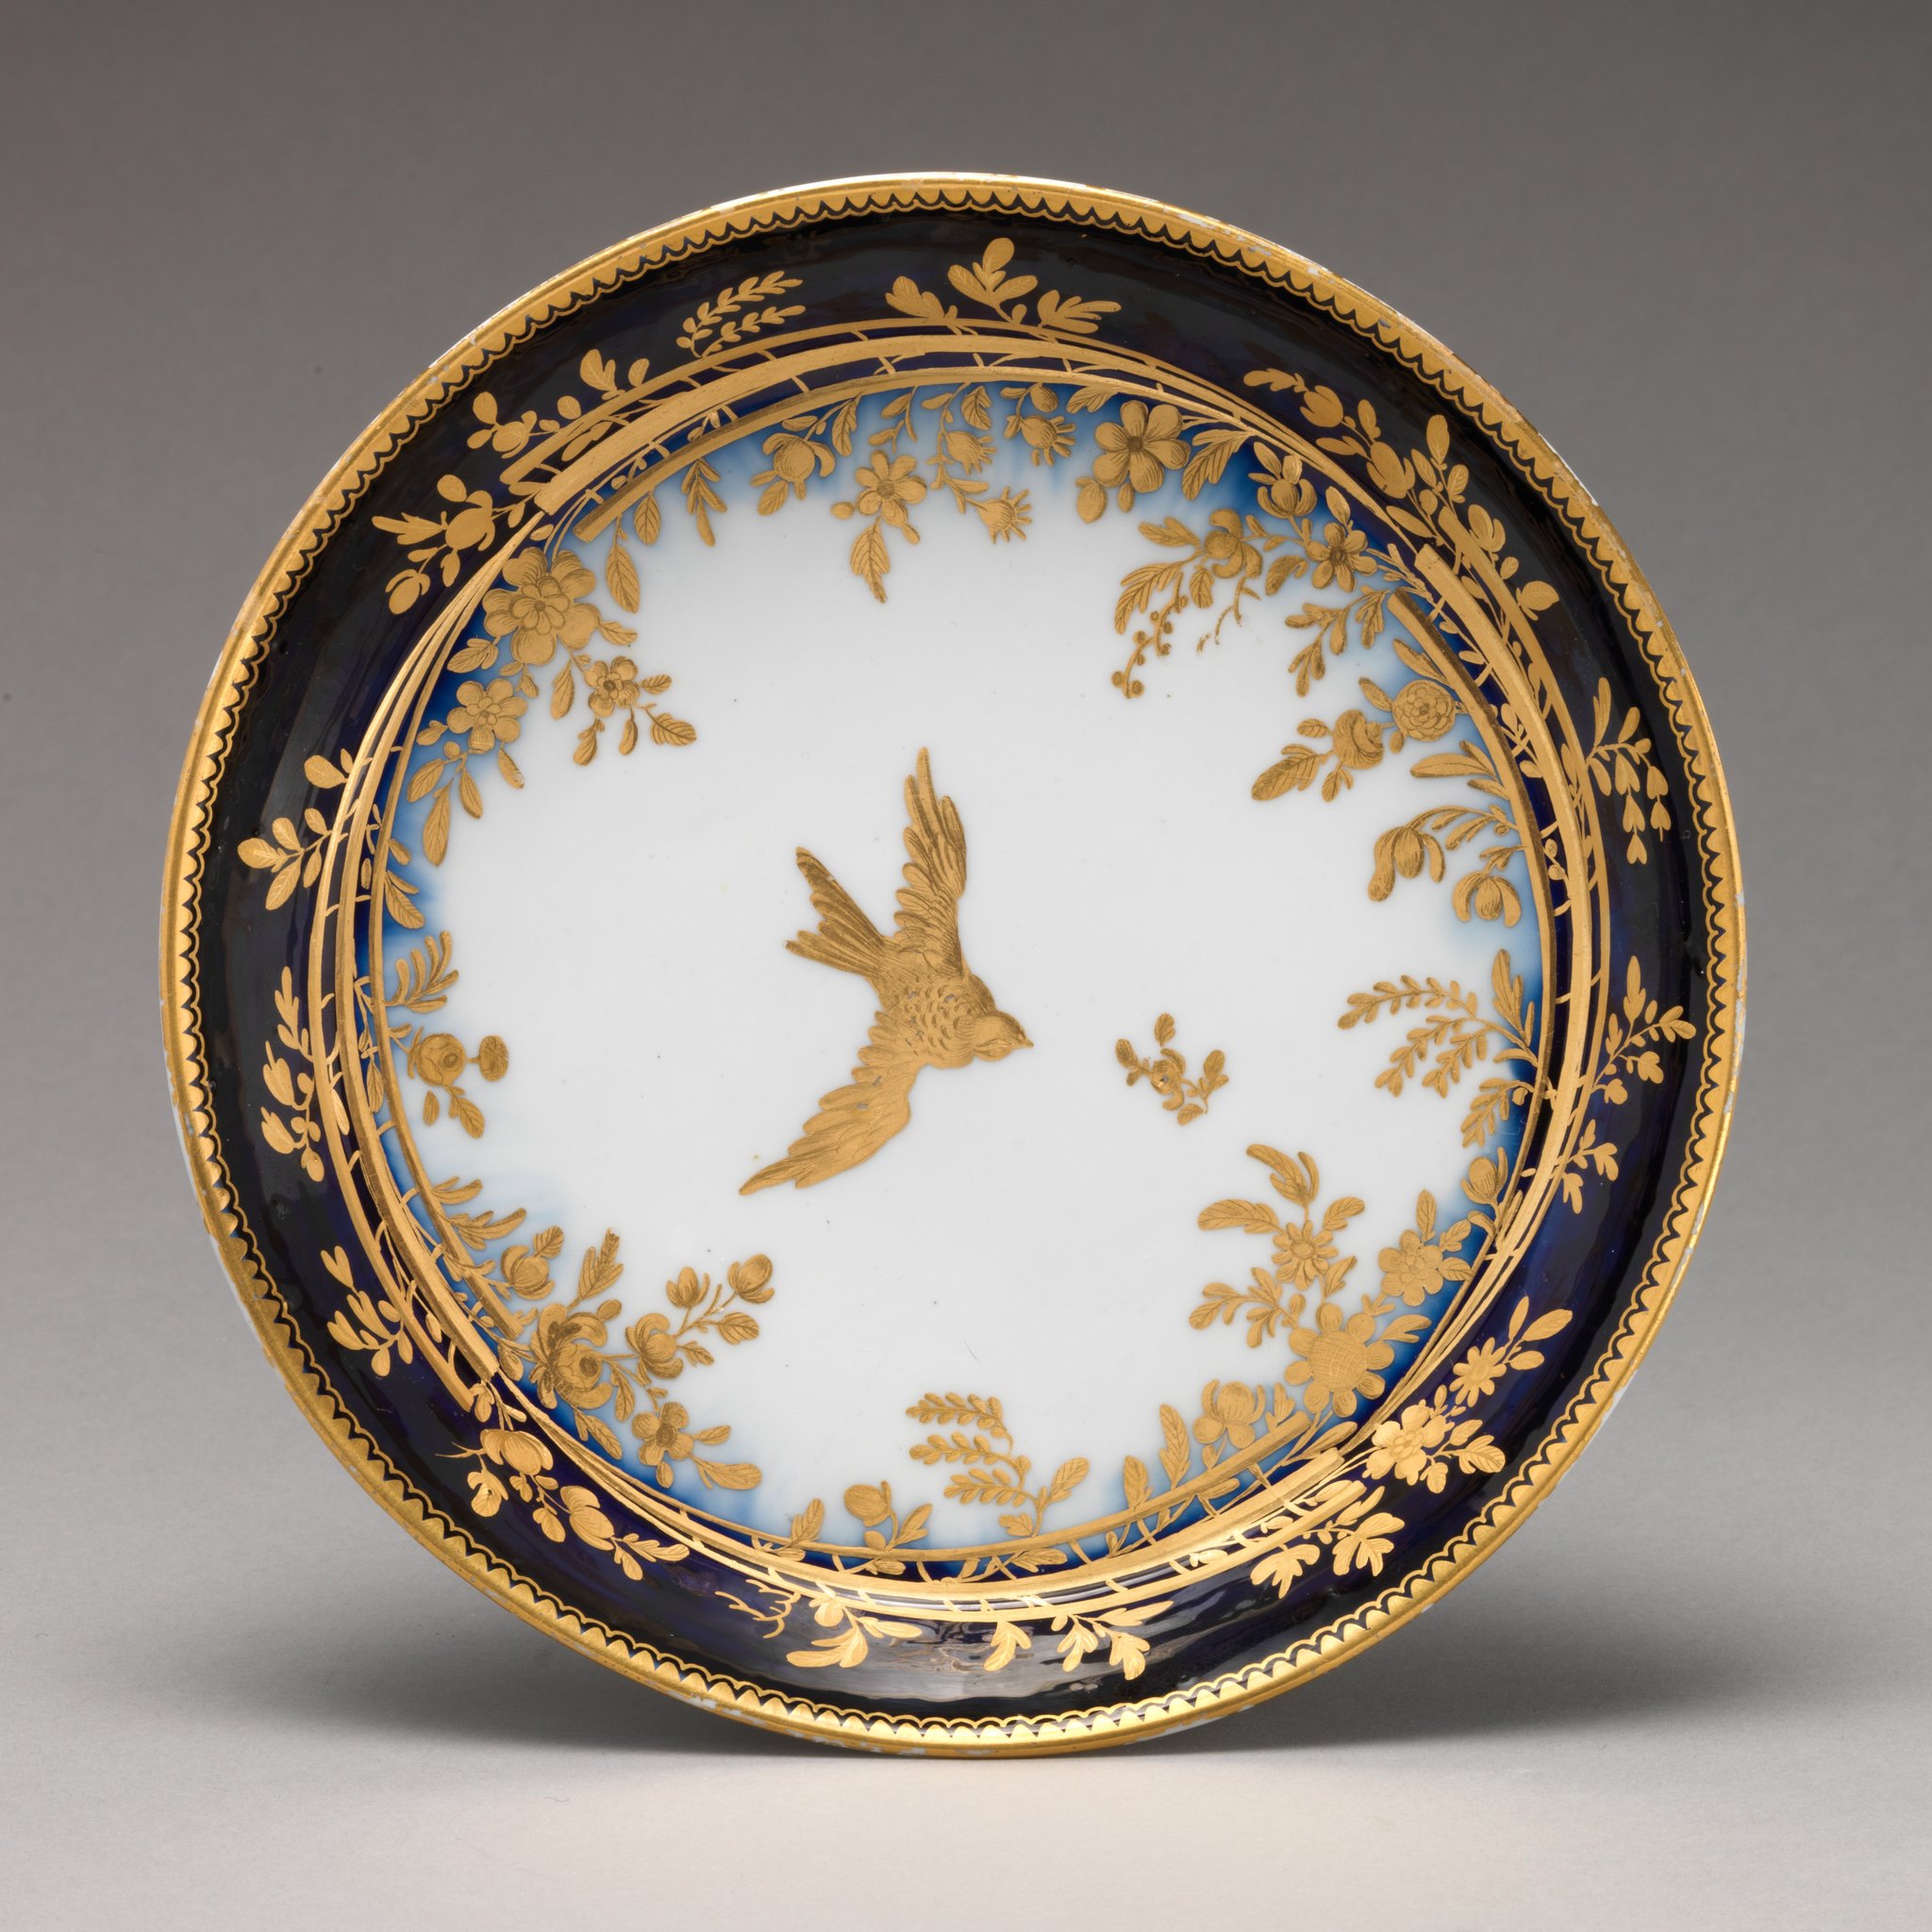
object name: teapot stand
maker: chelsea porcelain manufactory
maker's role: factory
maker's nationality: british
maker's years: 1744-1784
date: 1758-1769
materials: enamel, soft paste porcelain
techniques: gilding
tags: birds,flowers